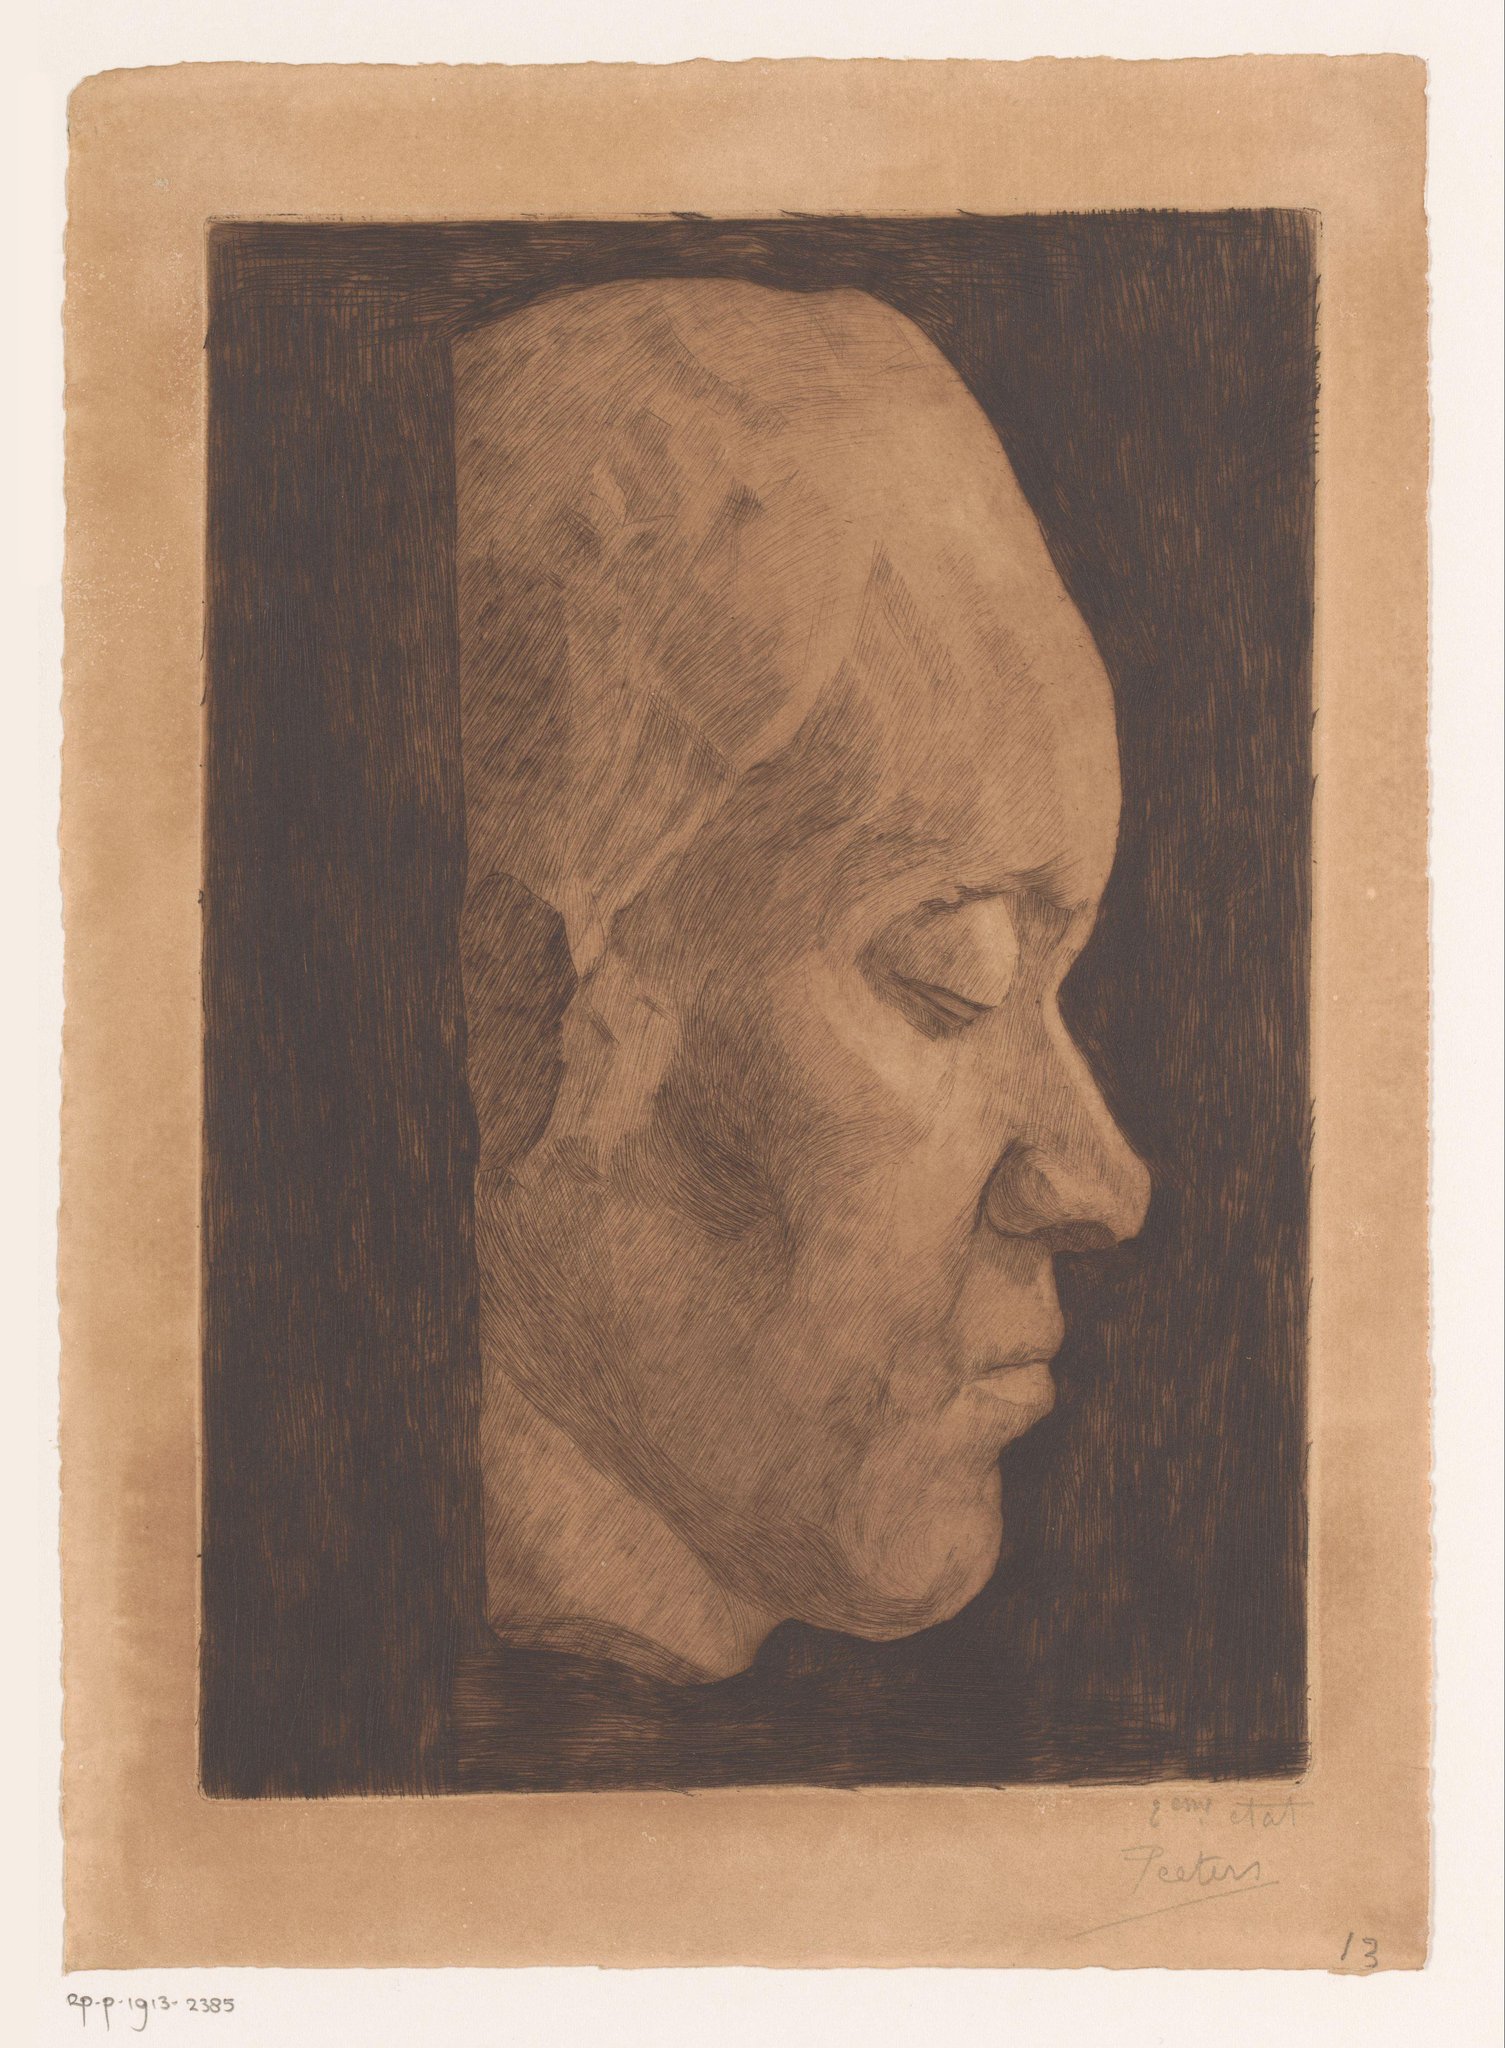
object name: print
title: Masker van Beethoven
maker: pierre peeters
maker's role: print maker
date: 1875-1913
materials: paper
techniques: drypoint, etching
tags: vienna, face - aa - mask (mould taken from face)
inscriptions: annotation: ‘2me état’, collector's mark: Lugt 2228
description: Hoewel dit masker vaak foutief wordt aangeduid als doodsmasker, werd dit tijdens het leven van Beethoven door Franz Klein gemaakt. Er bestaat ook een doodsmasker, enkele uren na Beethovens overlijden gemaakt door Josef Danhauser. Geboorte- en sterfdatum van de prentmaker zijn onbekend. Daarom is voor de bepaling van de rechten van dit object gebruik gemaakt van de verwervingsdatum Rijksmuseum Amsterdam.